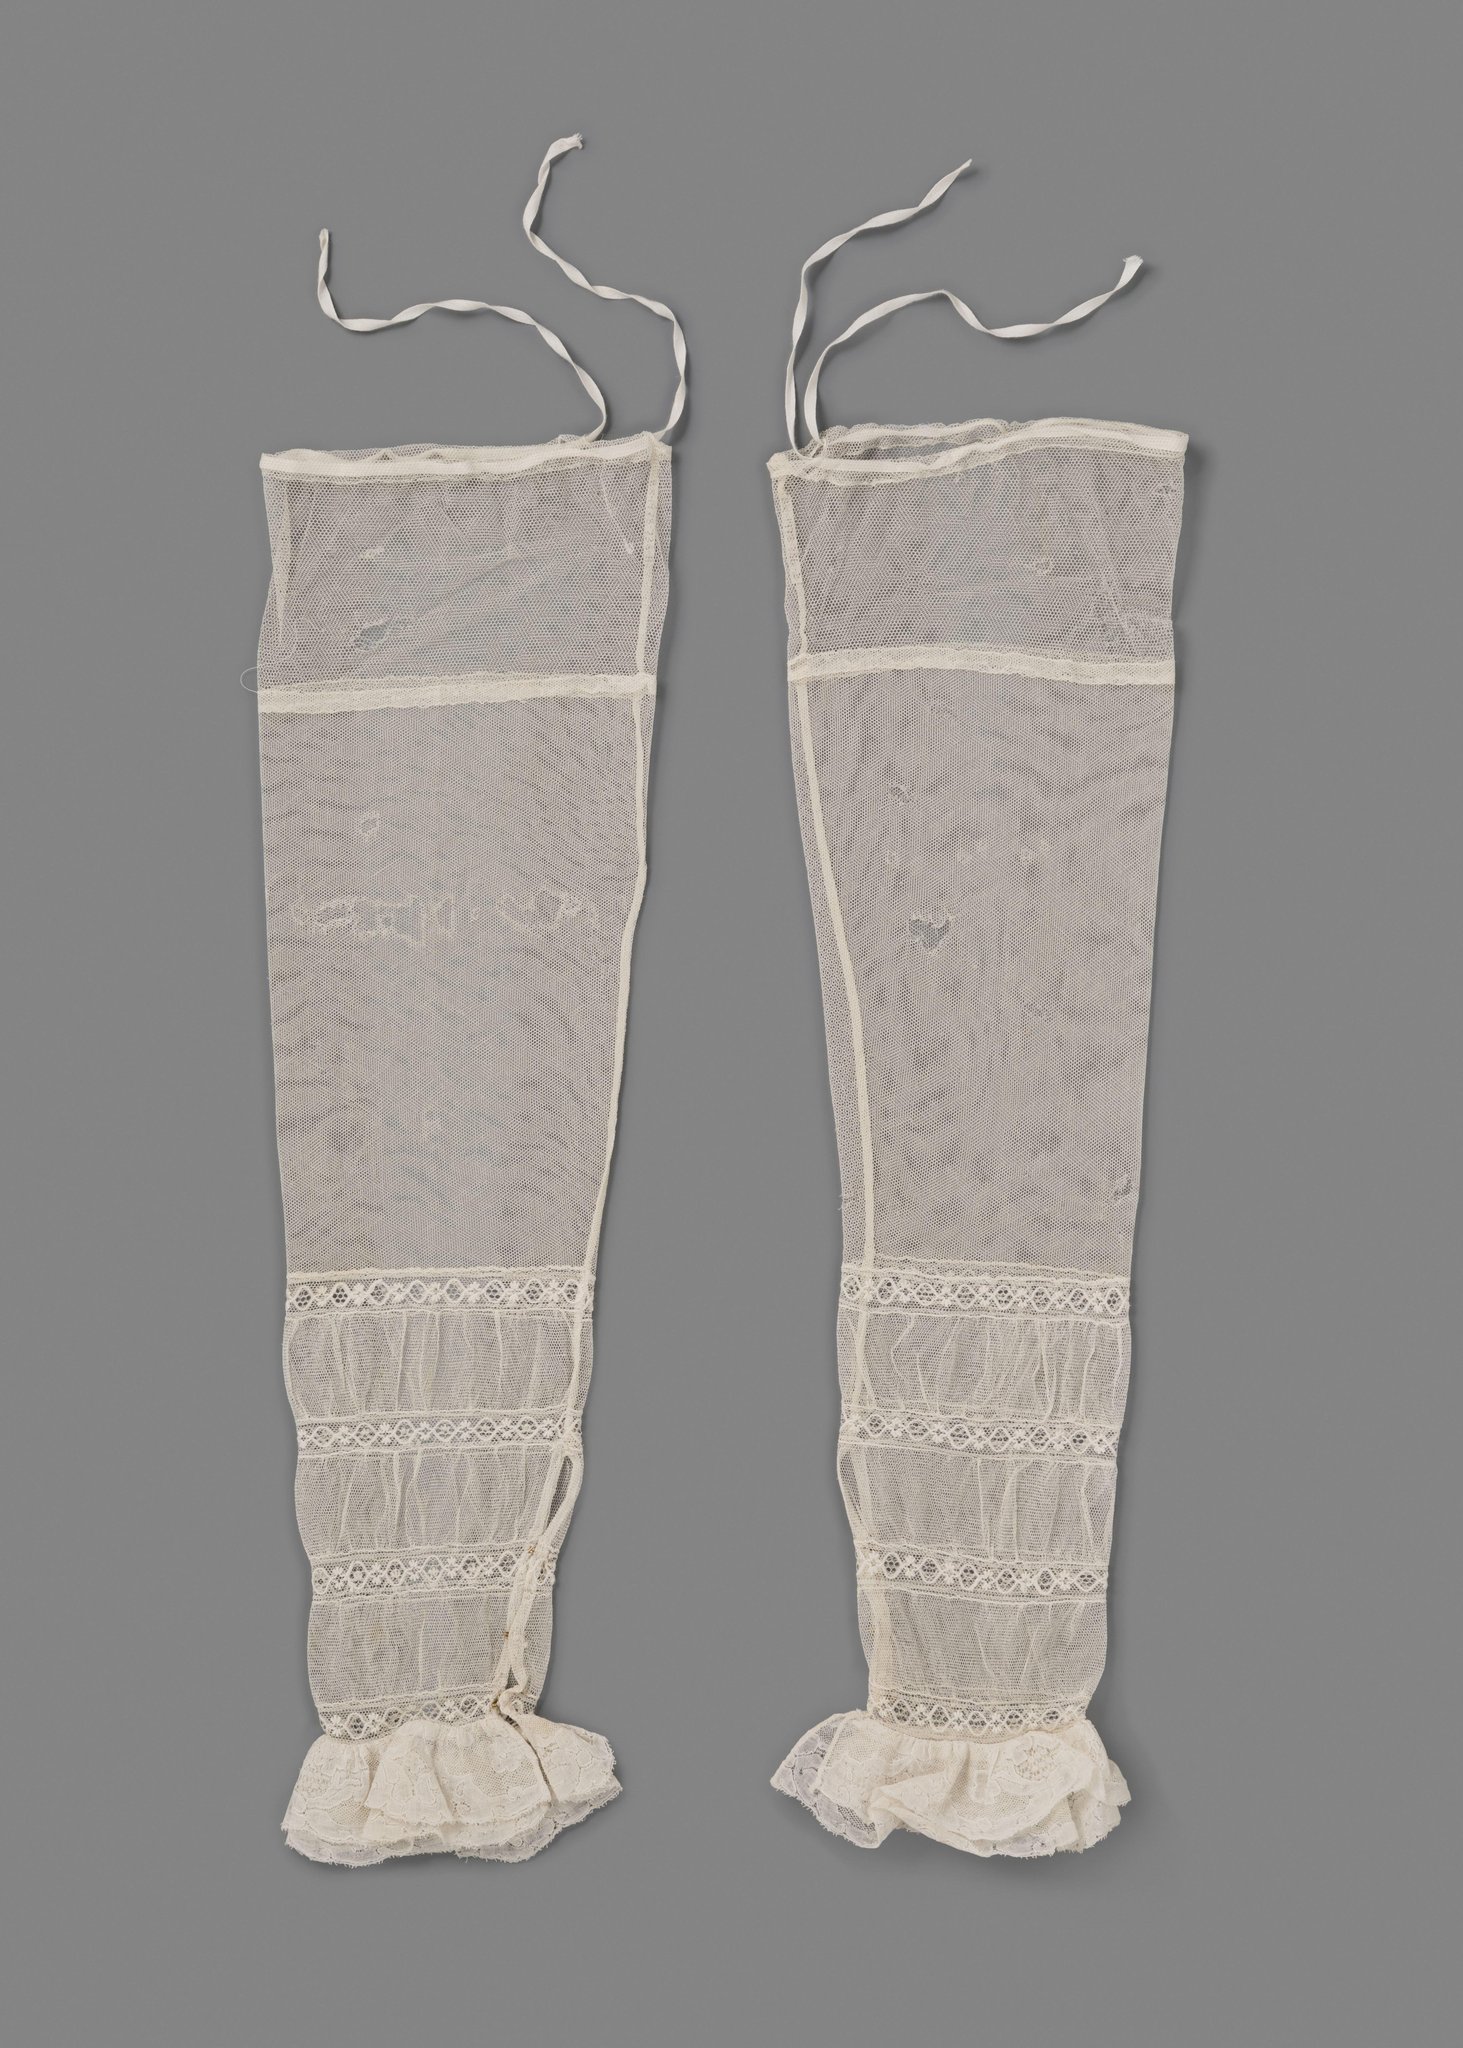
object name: leg of mutton sleeve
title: Mouw van tule met vier tussenzetsels en een dubbele ruche van Mechelse kant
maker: Anonymous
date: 1740-1760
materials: metal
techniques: lace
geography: mechelen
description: Paar losse ballon mouwen van tulle met tussenzetsels en mechelse klos kant. Restauration. Model: lange slanke snit. Vanboven intrekbaar met bandje. Onderaan een dubbele ruche van oudere kloskant. Halverwege beginnen vier opengewerkte tussenzetsels die de mouw met drie, matig gerimpelde ballons onsnoeren. Kant: De Mechelse kant (ijsgrond en dikkere contourdraad) heeft een vol patroon dat van symmetrische voluutbladeren is, afgewisseld door een grote rozebloem tussen steeltjes rond een rasterveld. Toestand: In 1978 gewassen.